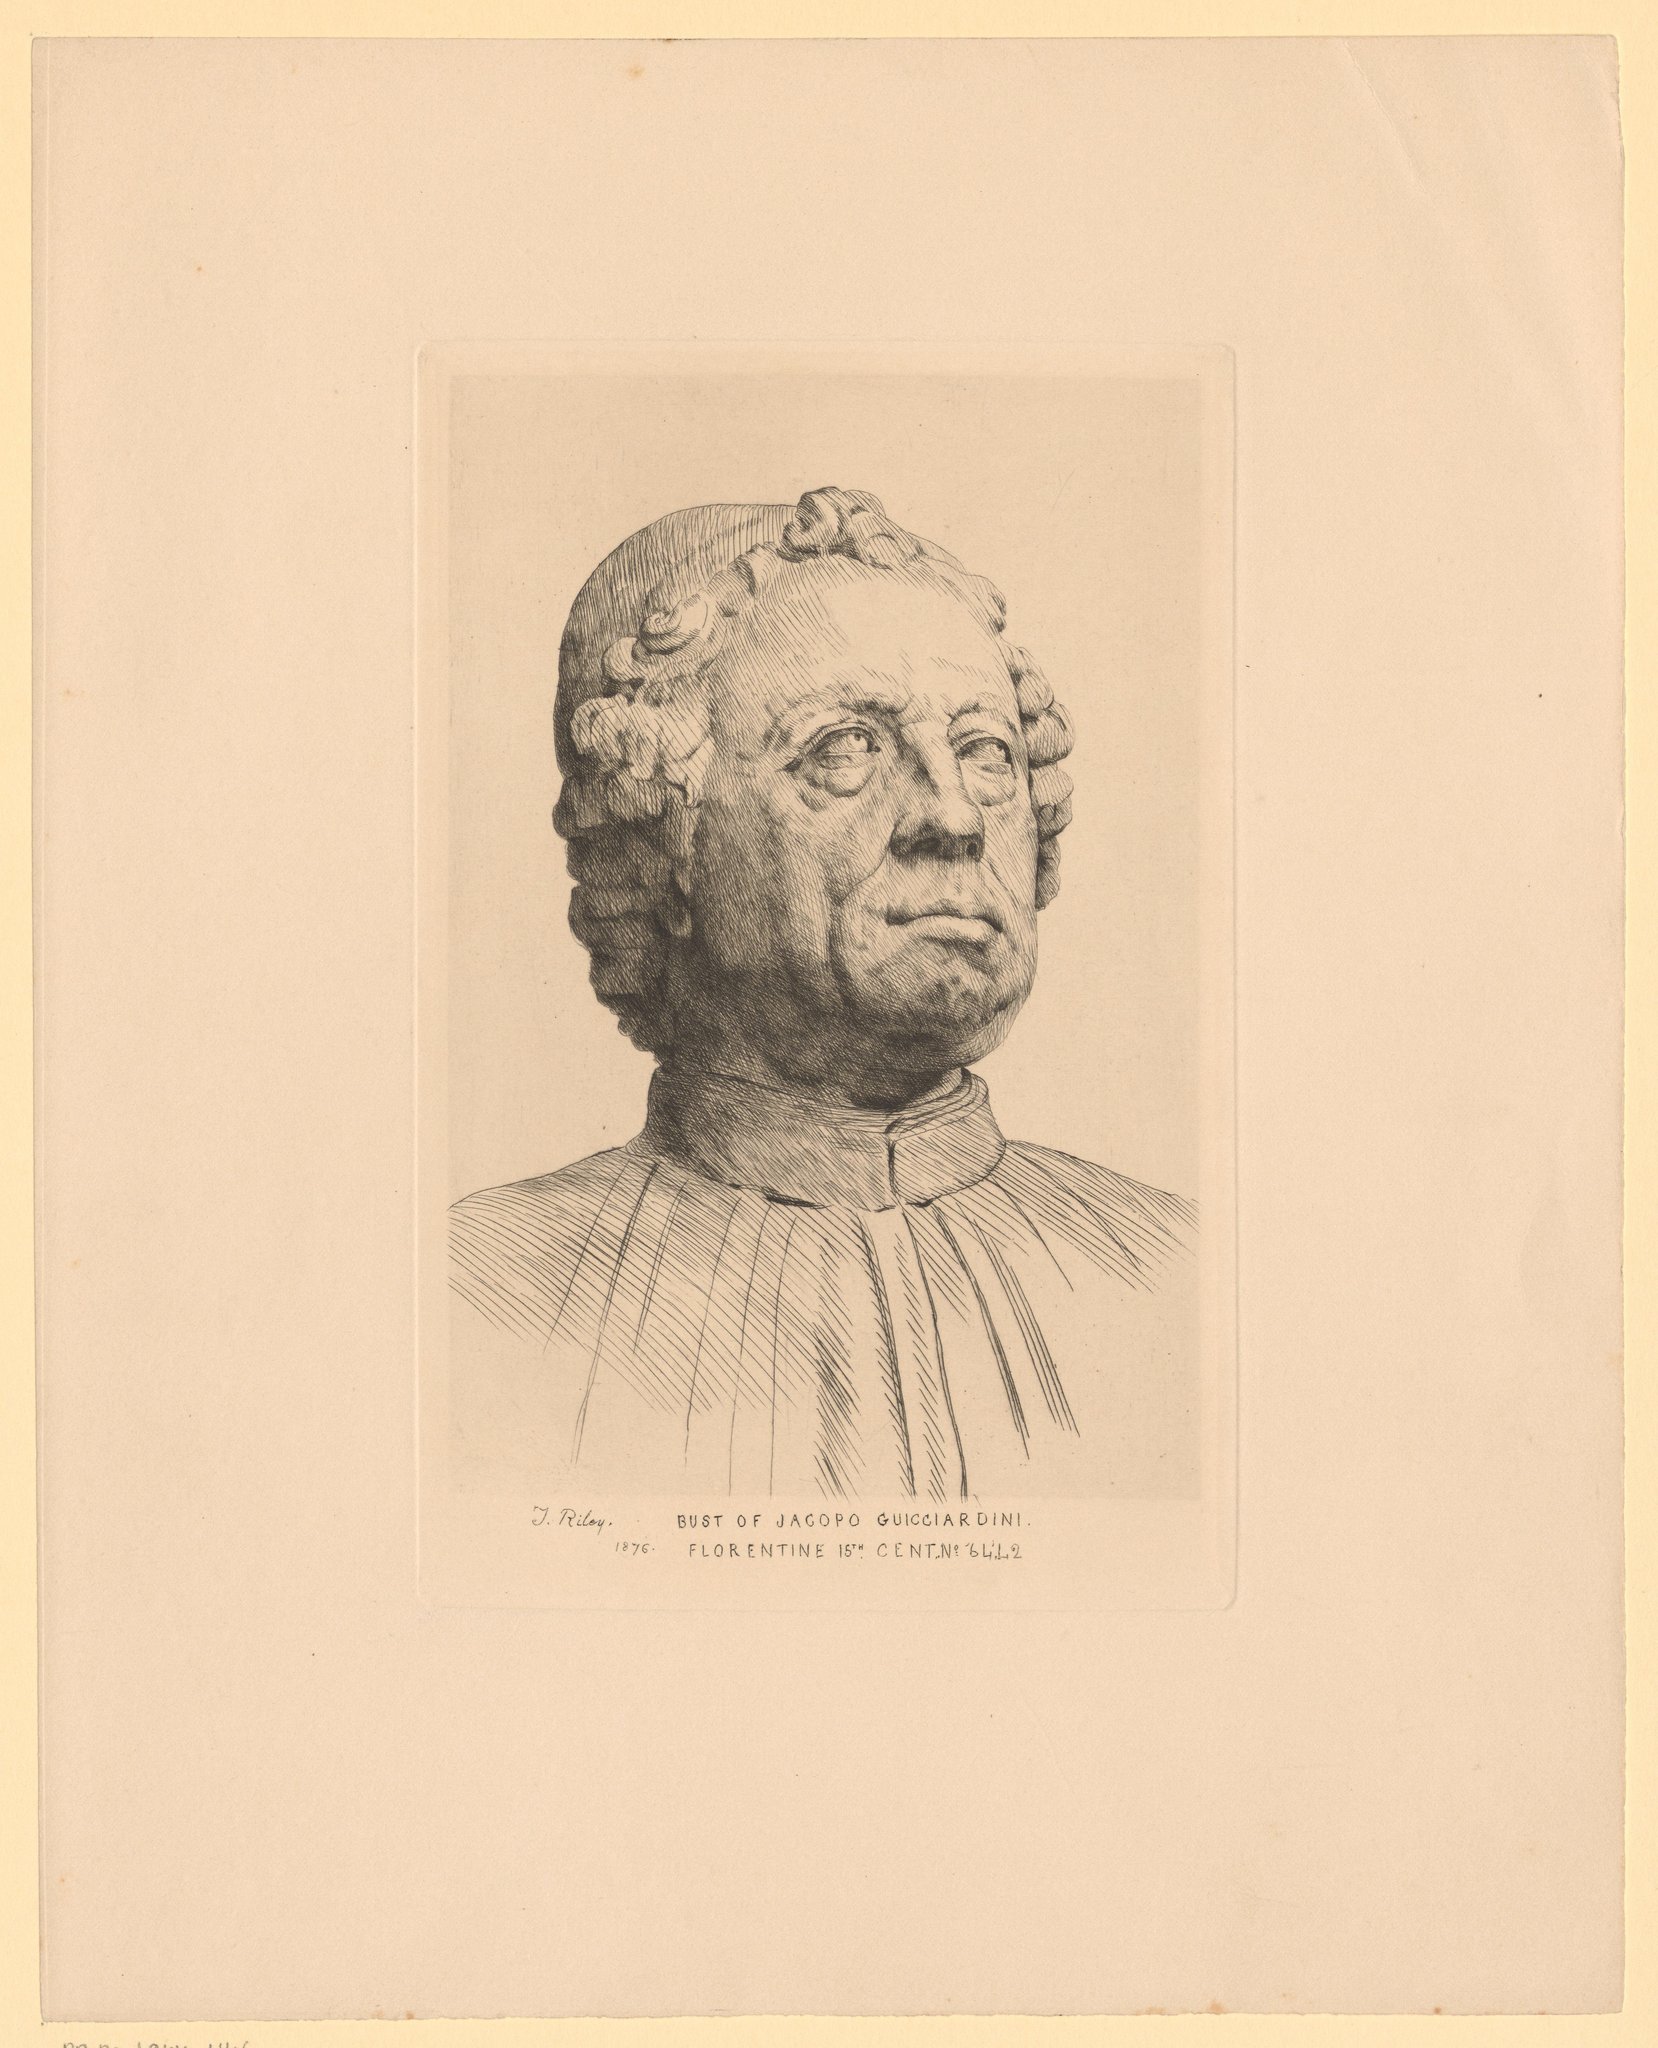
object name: print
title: Portret van Jacopo Guicciardini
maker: thomas riley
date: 1876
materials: paper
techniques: etching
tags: politician, historical persons, politician, e.g. party leader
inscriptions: collector's mark: Lugt 2228